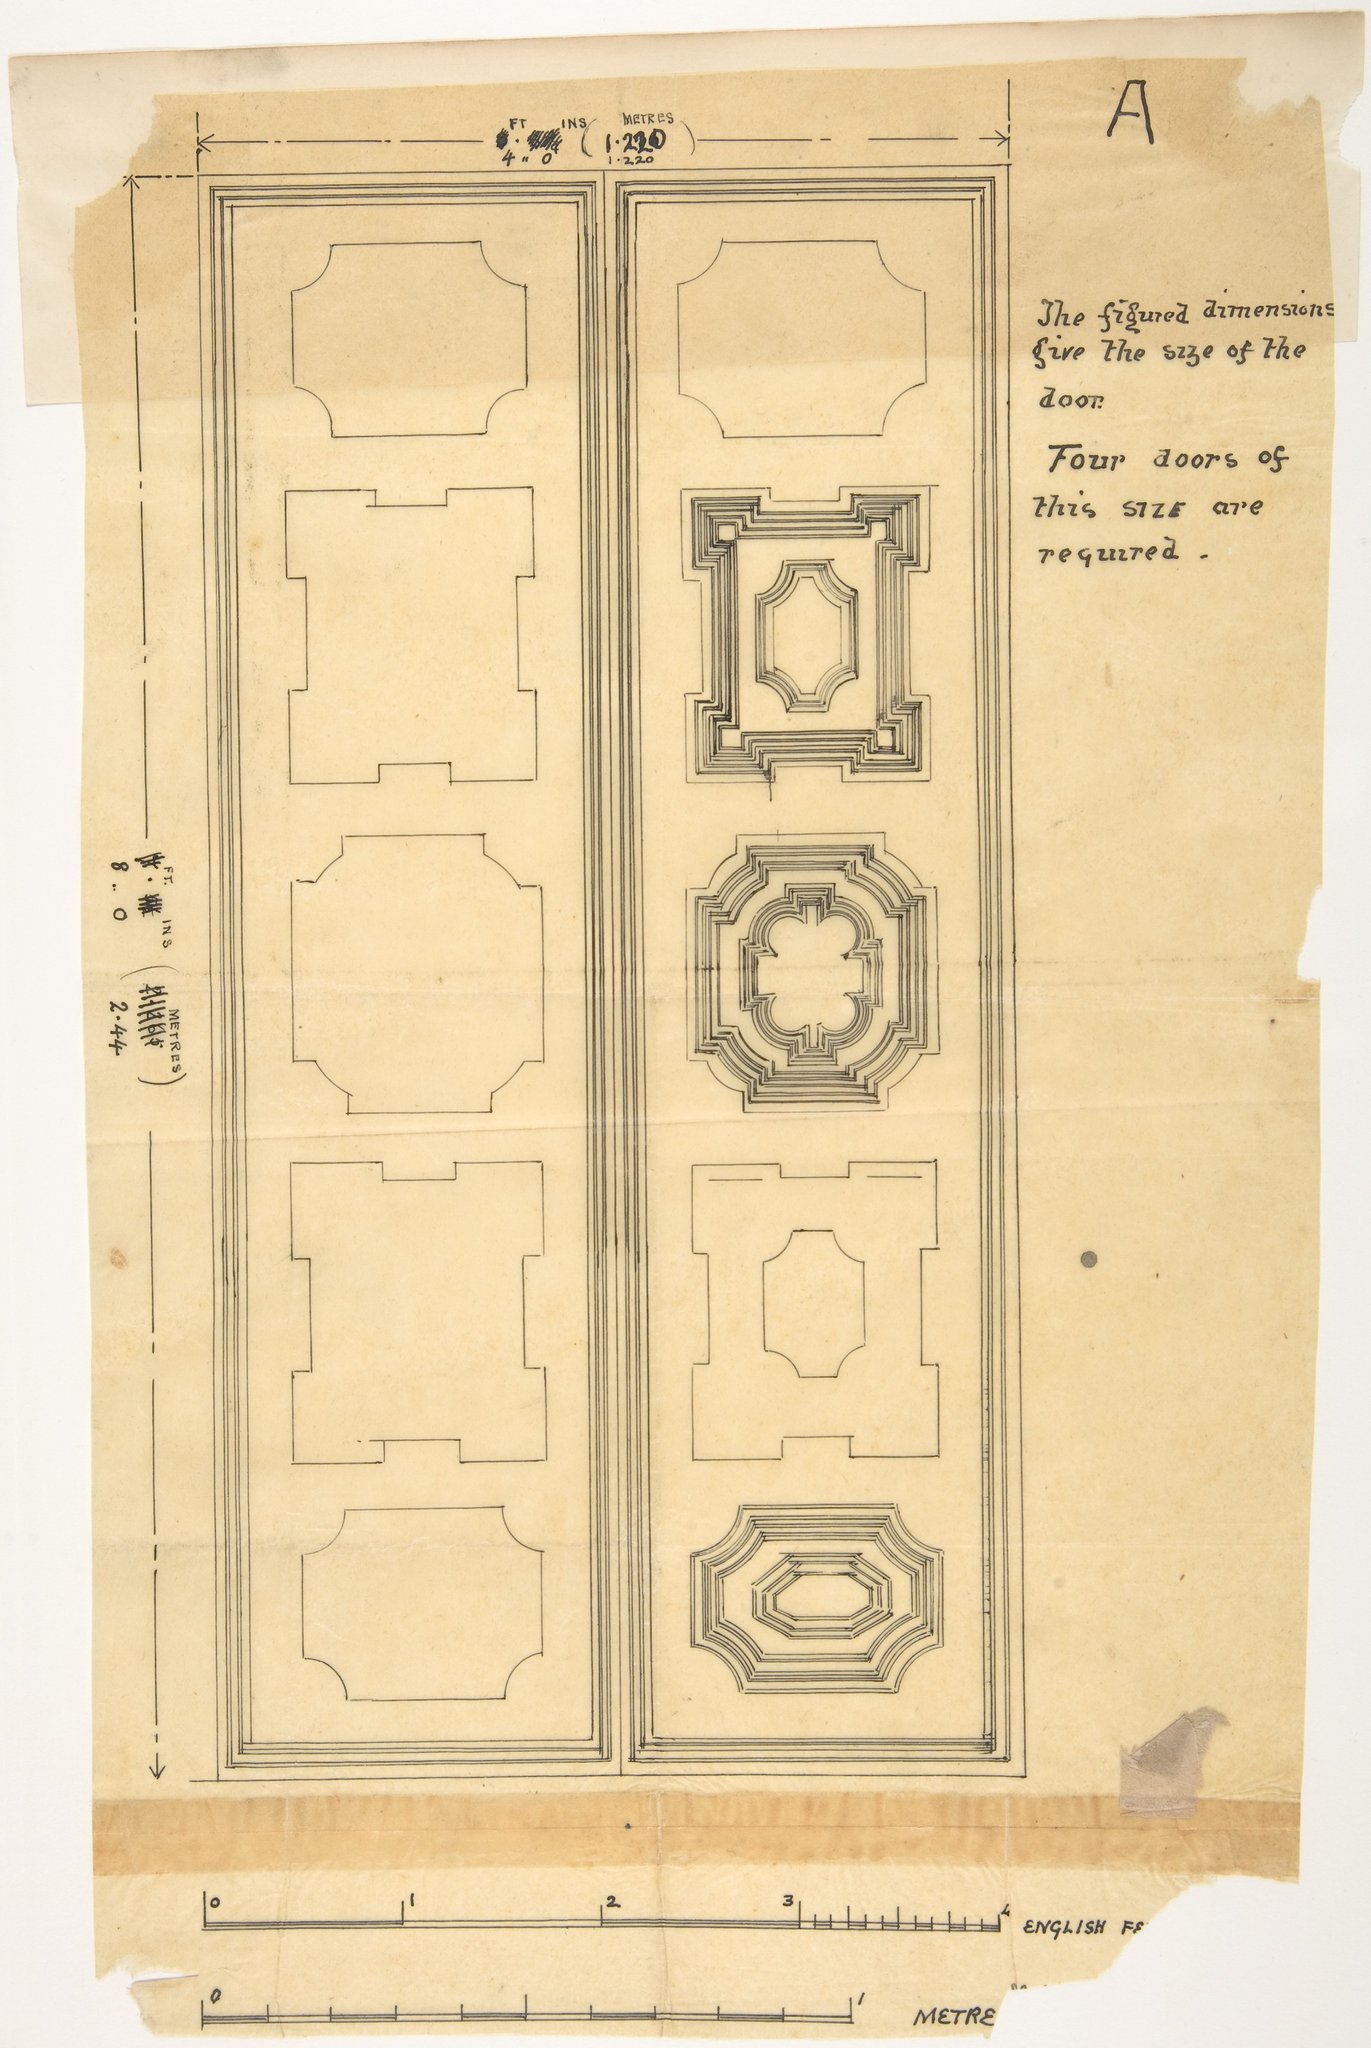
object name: drawing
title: Design for a Door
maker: anonymous, british, 19th century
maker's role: artist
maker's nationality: british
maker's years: 1800-1900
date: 1801-1900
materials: ink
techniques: pen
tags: doors